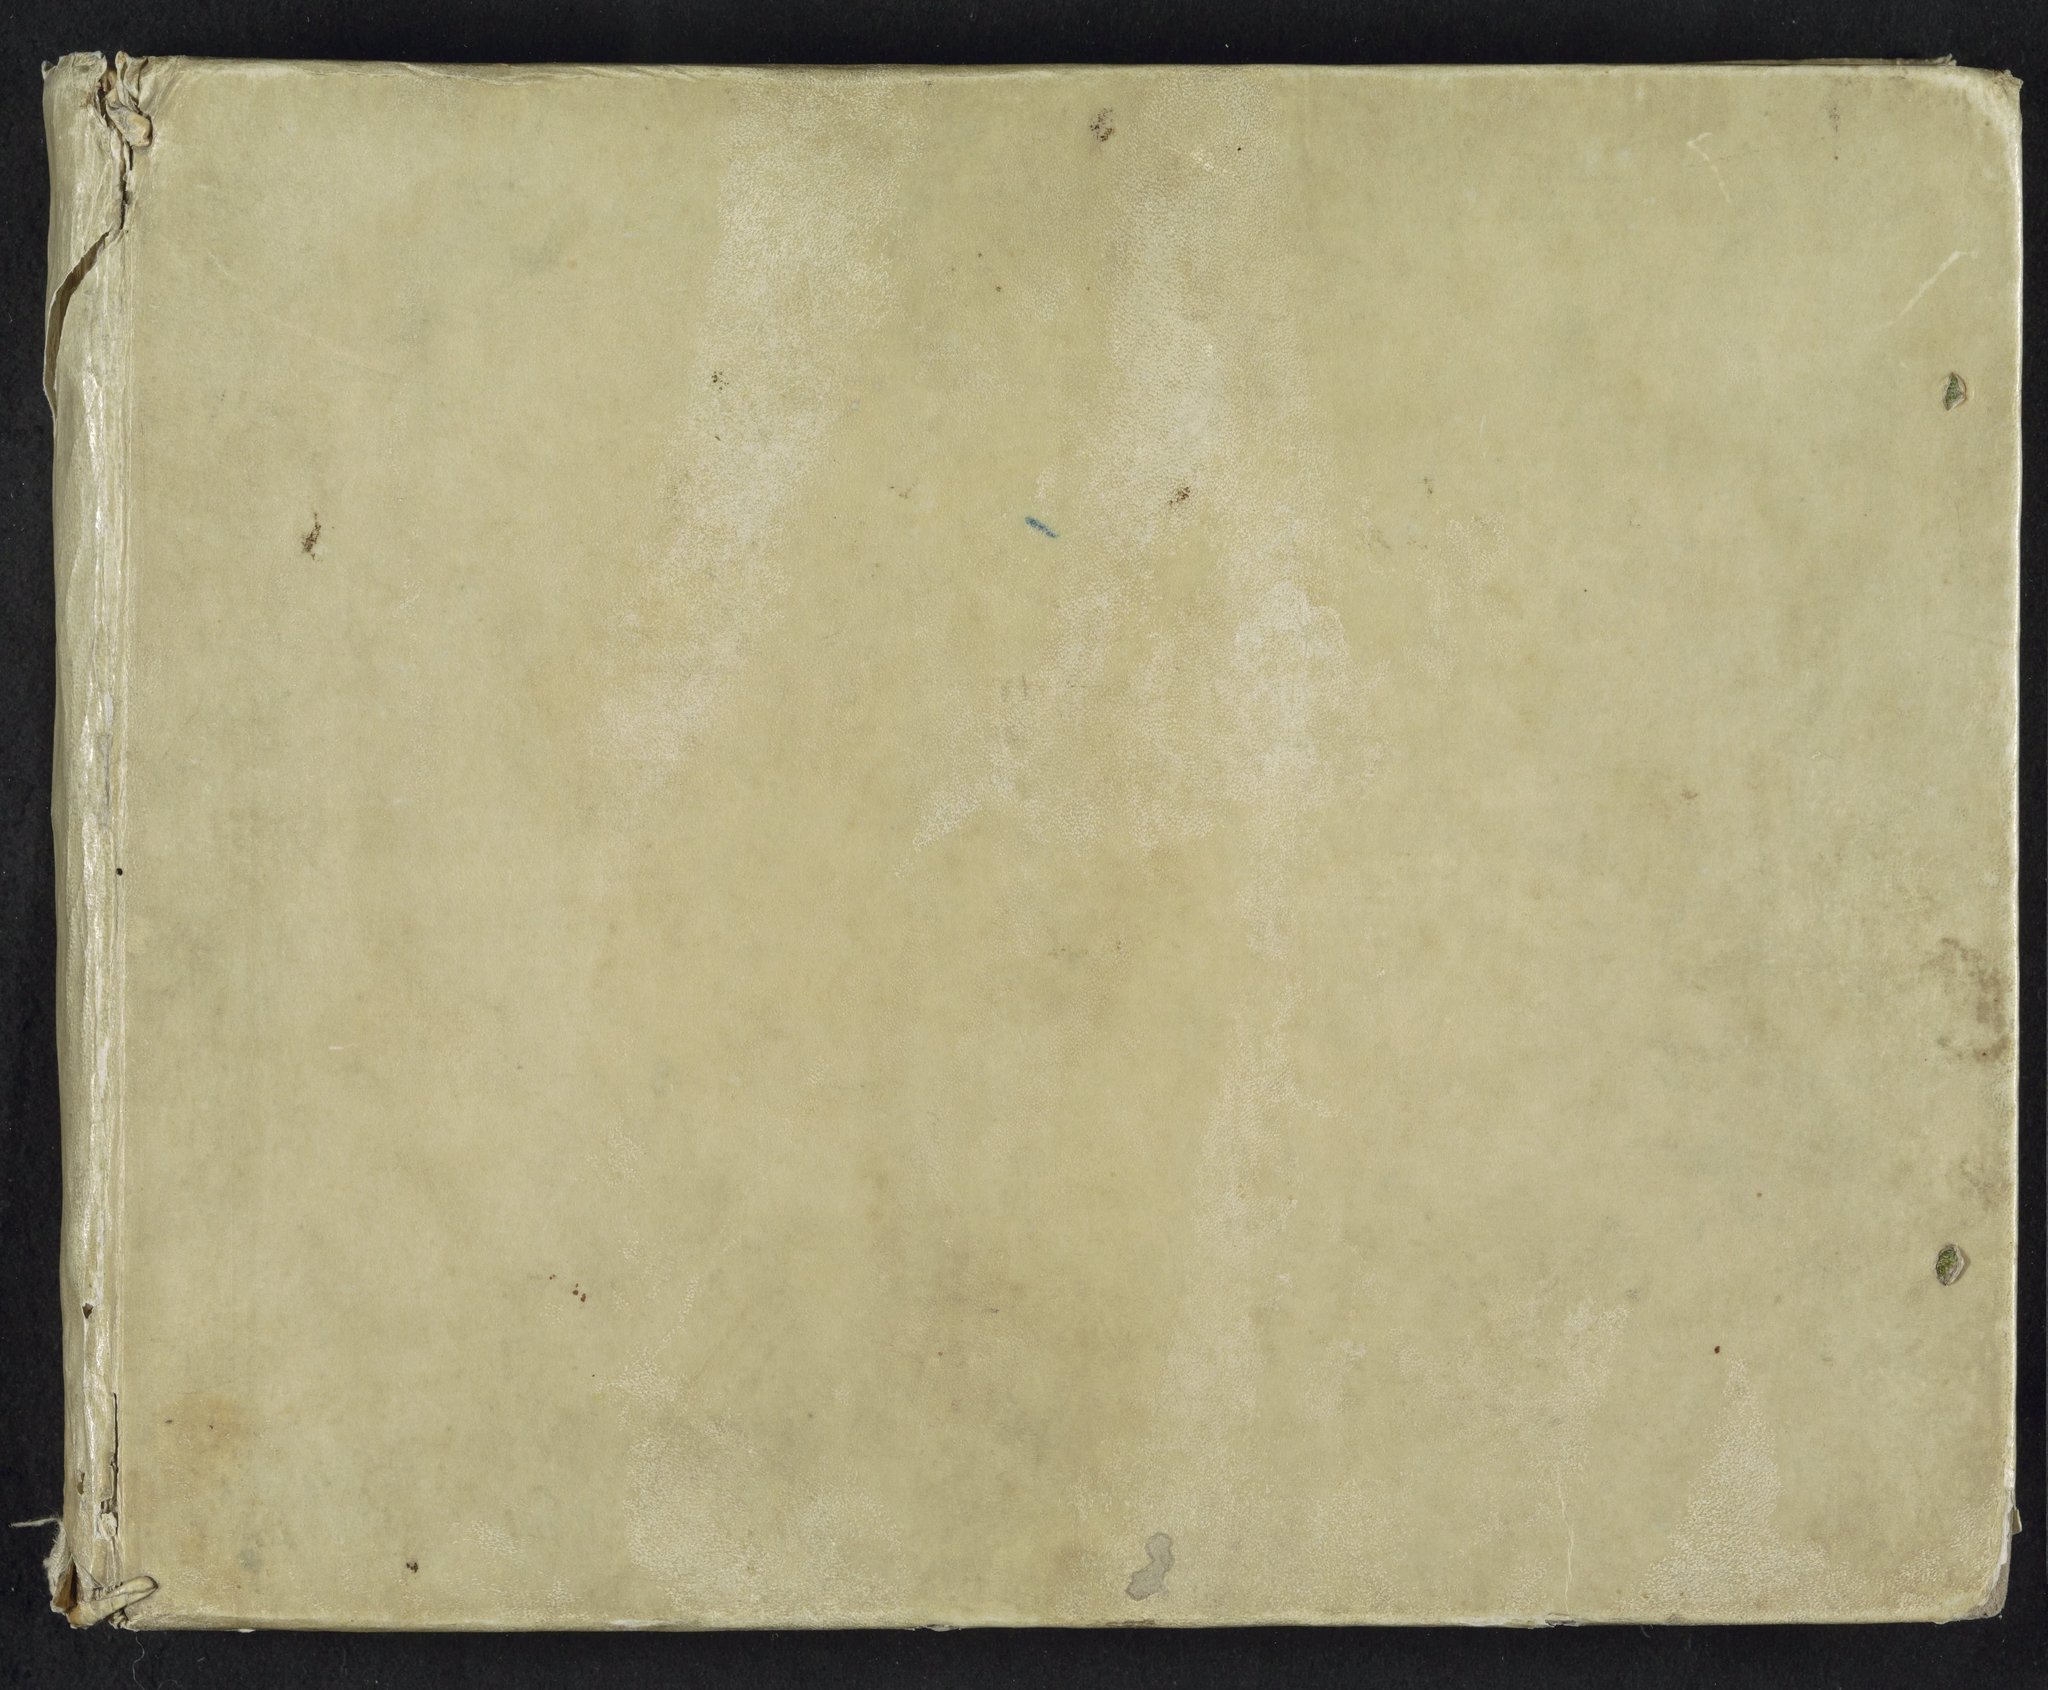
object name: picture bible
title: Thesaurus novi testamenti elegantissimis iconibus expressus continens historias atque miracula doni nostri Iesu Christi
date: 1585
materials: paper, parchment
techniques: bookbinding, engraving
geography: antwerp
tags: new testament, old testament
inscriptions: collector's mark: Lugt 2228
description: Dit exemplaar van Thesaurus sacrarum historiaru[m] veteris testame[n]ti bevat de prenten uit de uitgave van 1585 van Gerard de Jode en is ook zo gedateerd op de titelprent voor het Oude Testament. Het album bevat echter een serie die later moet worden gedateerd. De serie Handelingen van de apostelen (RP-P-1988-312-342 t/m RP-P-1988-312-353) draagt op een van de prenten het signatuur van de weduwe van Gerard de Jode. Met dit signatuur is deze serie tussen 1591, het sterfjaar van Gerard de Jode, en 1600, het jaar waarin zijn zoon overleed en de platen werden verkocht, te dateren. Het is mogelijk dat deze serie later aan het album is toegevoegd. Waarschijnlijker is het dat het gehele album tussen 1591 en 1600 is uitgegeven, omdat deze serie is meegebonden in het album. Albumblad met objectnummer RP-P-1988-312-13 is toegevoegd aan het album door de prent met een strook vast te plakken aan de volgende prent in dezelfde serie van de Geschiedenis van de toren van Babel. Wellicht miste de prent met deze voorstelling in dit album of was deze eruit verdwenen. Het gaat hier om een latere staat die is uitgegeven door Claes Jansz. Visscher. Deze kan op zijn vroegst vanaf 1606 bewerkt zijn door Claes Jansz. Visscher. Het originele albumblad met de prent van Susanna en de ouderlingen, moet eens uit het album zijn verwijderd. Een afgesneden blad is nog te zien. Hetzelfde of, wat waarschijnlijker is, een ander exemplaar (objectnummer RP-P-1988-312-177A), van deze prent is toegevoegd aan het album door de prent met een strook vast te plakken aan de volgende prent in dezelfde serie. Dit blad is kleiner dan de andere bladen. Albumblad met objectnummer RP-P-1988-312-327 is eveneens toegevoegd aan het album door de prent met een strook vast te plakken aan de volgende prent in het album. De prent is dus niet mee gebonden. Dit blad is kleiner dan de andere bladen.